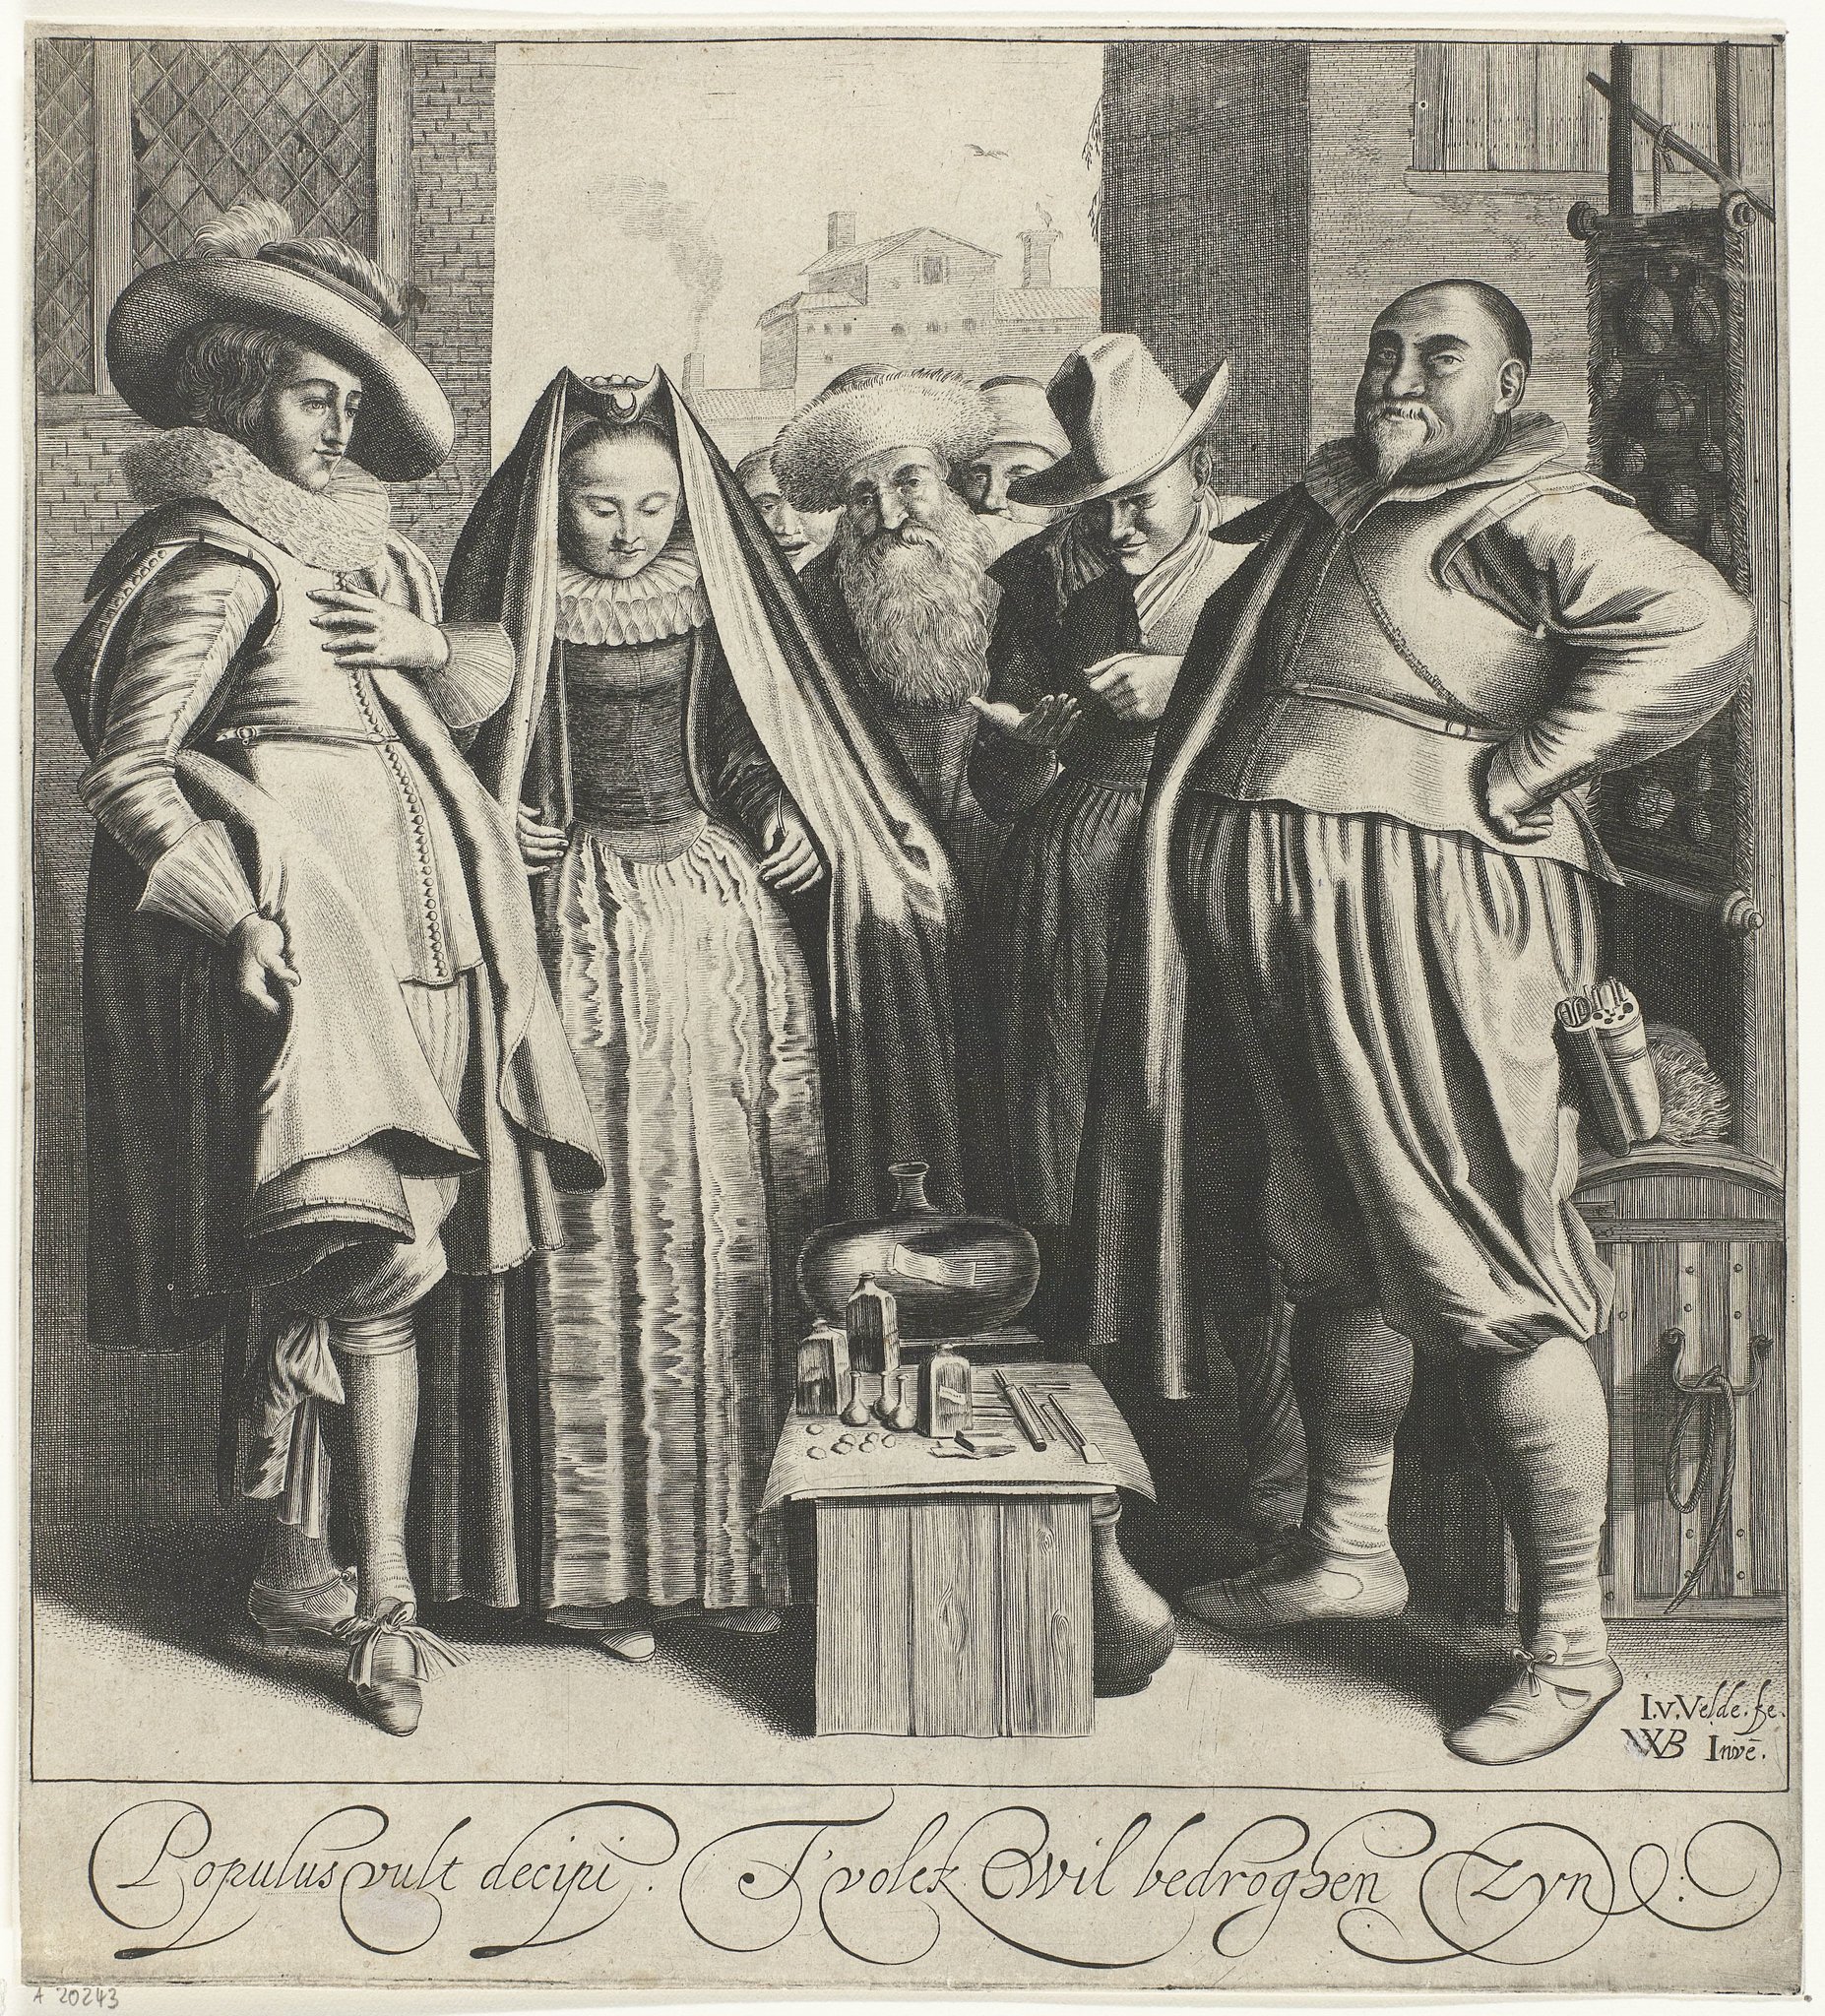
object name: print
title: Kwakzalver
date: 1603-1641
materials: paper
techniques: engraving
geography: northern netherlands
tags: head-gear: hat (+ fur used for clothes), head-gear (with name), neck-gear ~ clothing (with name) (+ men's clothes), belt, girdle, waistband (+ men's clothes), cape (+ men's clothes), cape (huik) (+ women's clothes), quack, charlatan, mountebank, 'saltimbanco', clothes, costume (+ women's clothes), skirt (+ women's clothes), shoes, sandals (+ men's clothes), proverbs, sayings, etc., clothes, costume (+ men's clothes), clothing for the upper part of the body (with name) (+ women's clothes)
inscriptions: collector's mark: Lugt 964, title: ‘Populus vult decipi’, title: ‘T volck wil bedroghen zyn’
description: Een grote dikke man, de kwakzalver, staat voor een groep omstanders. Op een laag tafeltje staan zijn attributen: flessen, pincetten, mesjes en enkele 'stenen'. Een elegant paar staat voor hem. De heer naast hem zoekt in zijn hand geld om de kwakzalver te betalen. Naast hem een oude man met lange baard en bontmuts op. Achter de kwakzalver of 'keisnijder' hangt een doek aan twee stokken waarop stenen tentoongesteld zijn, als de zichtbare bewijzen van goed geslaagde 'kei-operaties'.